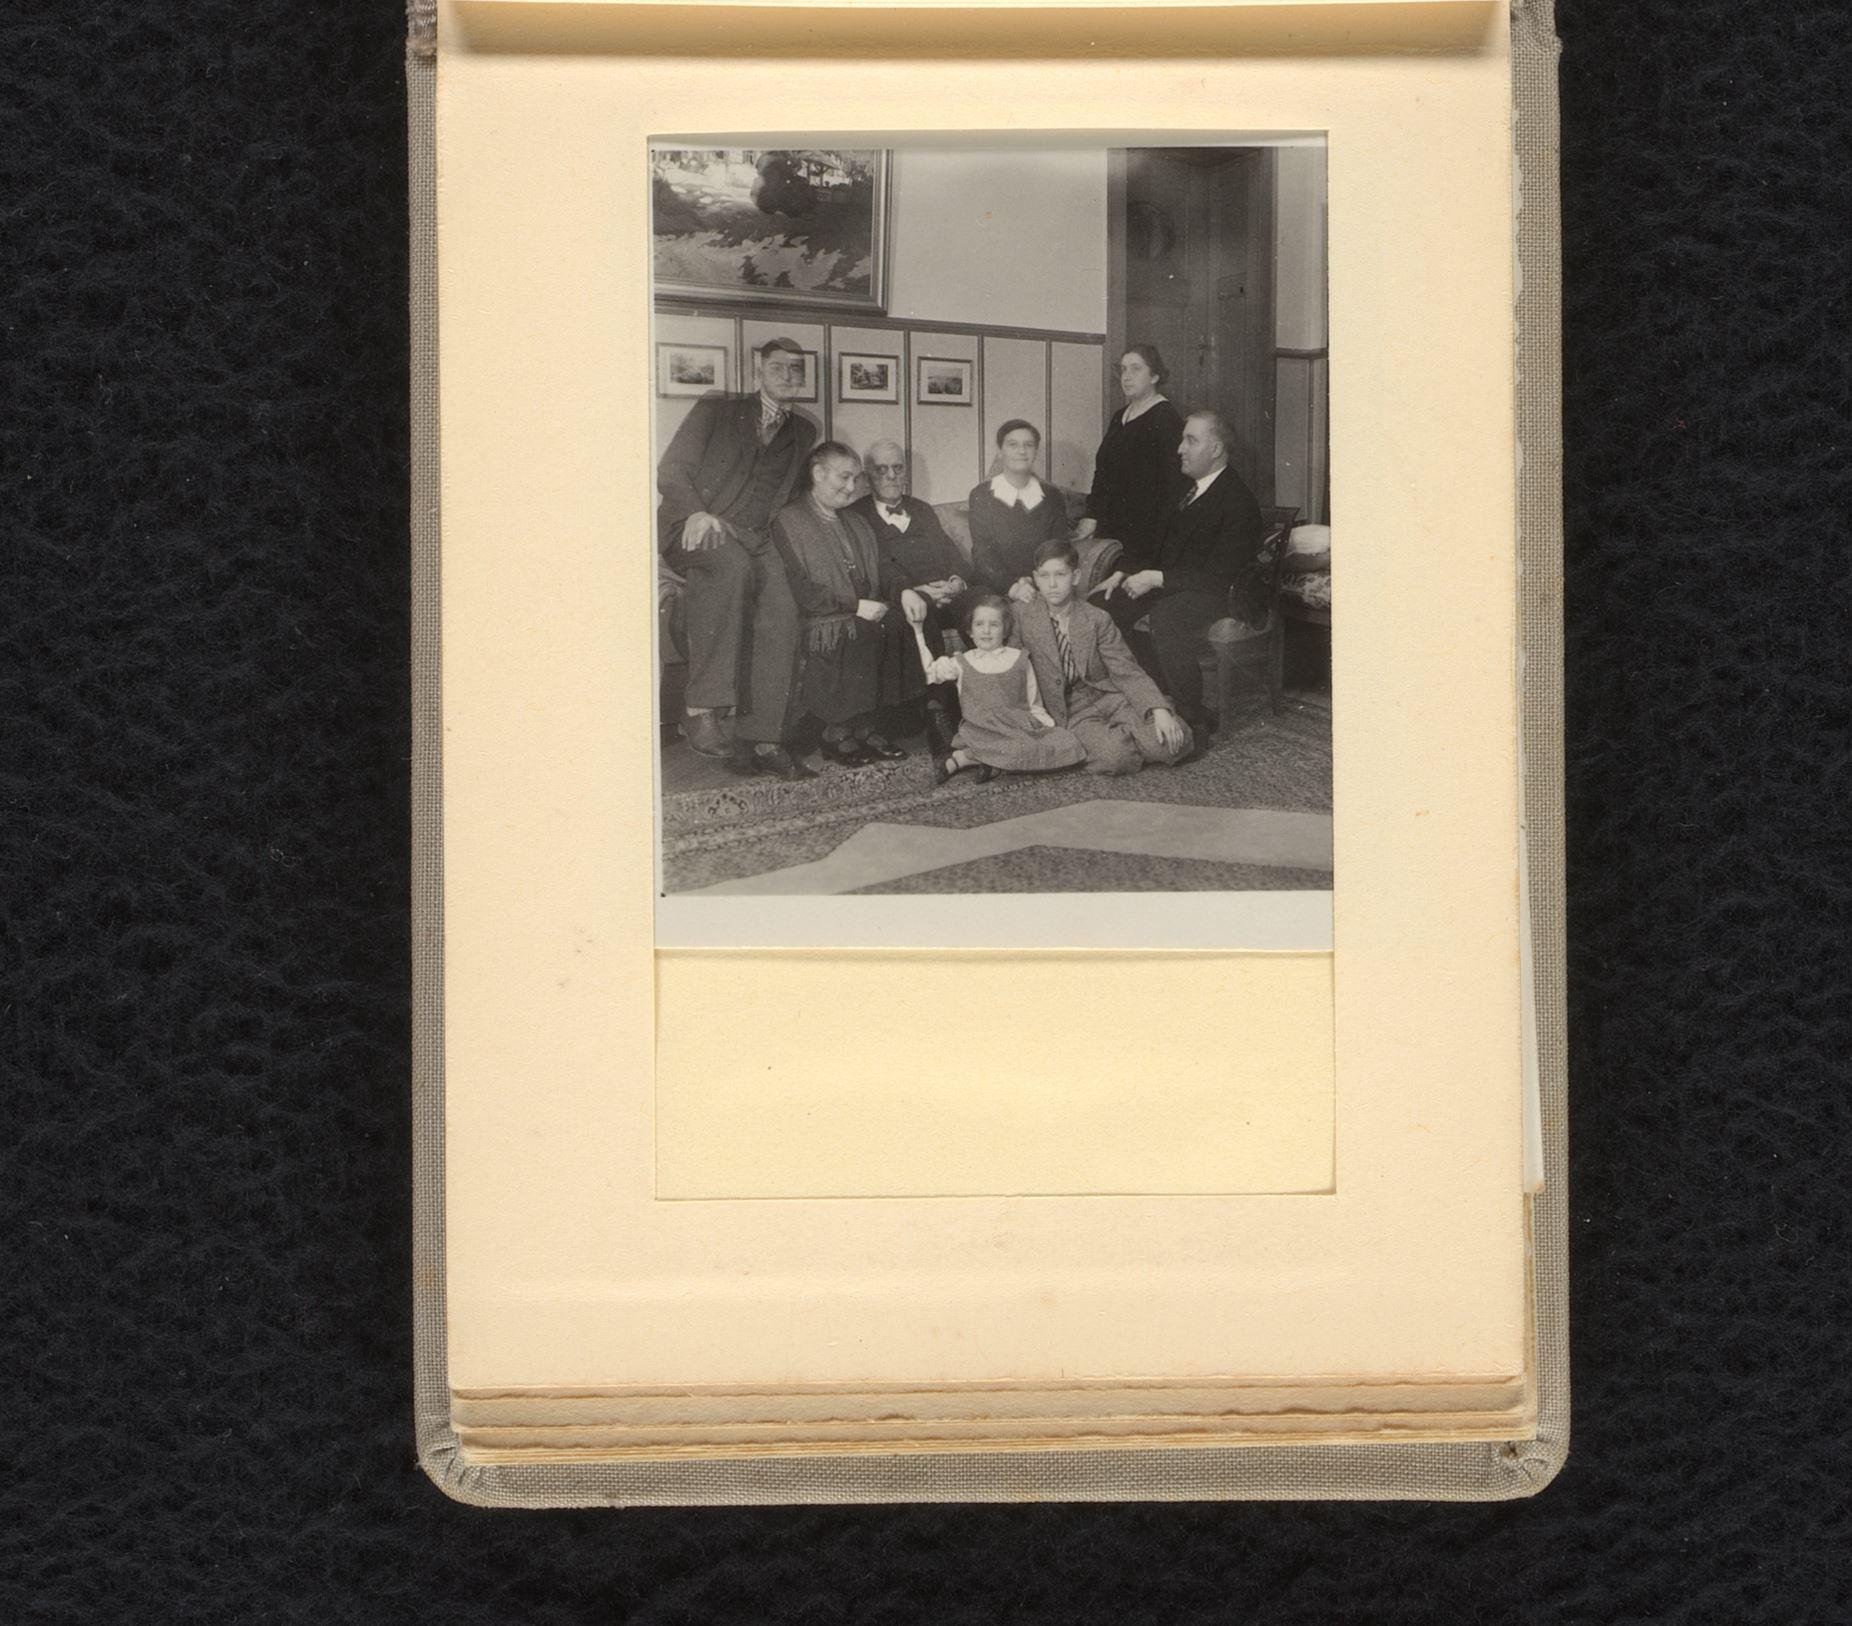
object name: album leaf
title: Isabel Wachenheimer tijdens familiebezoek met haar ouders Eugen Wachenheimer en Else Wachenheimer-Moos, haar grootouders Meir Wachenheimer en Mathilde Wachenheimer-Wertheimer, haar tante Liesel Wachenheimer-Zürndorfer en haar neven Klaus en Werner Zürndorfer, 1931-1935, Stuttgart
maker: isabel wachenheimer-elon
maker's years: 1928-2010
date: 1931-1935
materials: paper, photographic support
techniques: gelatin silver print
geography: stuttgart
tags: eugen wachenheimer, else wachenheimer-moos, leiden, isabel wachenheimer-elon, family life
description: Albumblad bevat een foto van Klaus Zürndorfer (links), Mathilde Wachenheimer-Wertheimer (2e van links), Meir Wachenheimer (3e van links), Liesel Wachenheimer-Zürndorfer (4e van links), Else Wachenheimer-Moos (5e van links), Eugen Wachenheimer (6e van links), Isabel Wachenheimer (voorgrond, 1e van links) en Werner Zürndorfer (voorgrond, 2e van links). Onderdeel van het fotoalbum met diverse foto's van de jeugd van Isabel Wachenheimer voor en tijdens de oorlog en diverse momenten van haar volwassen leven na de Tweede Wereldoorlog.